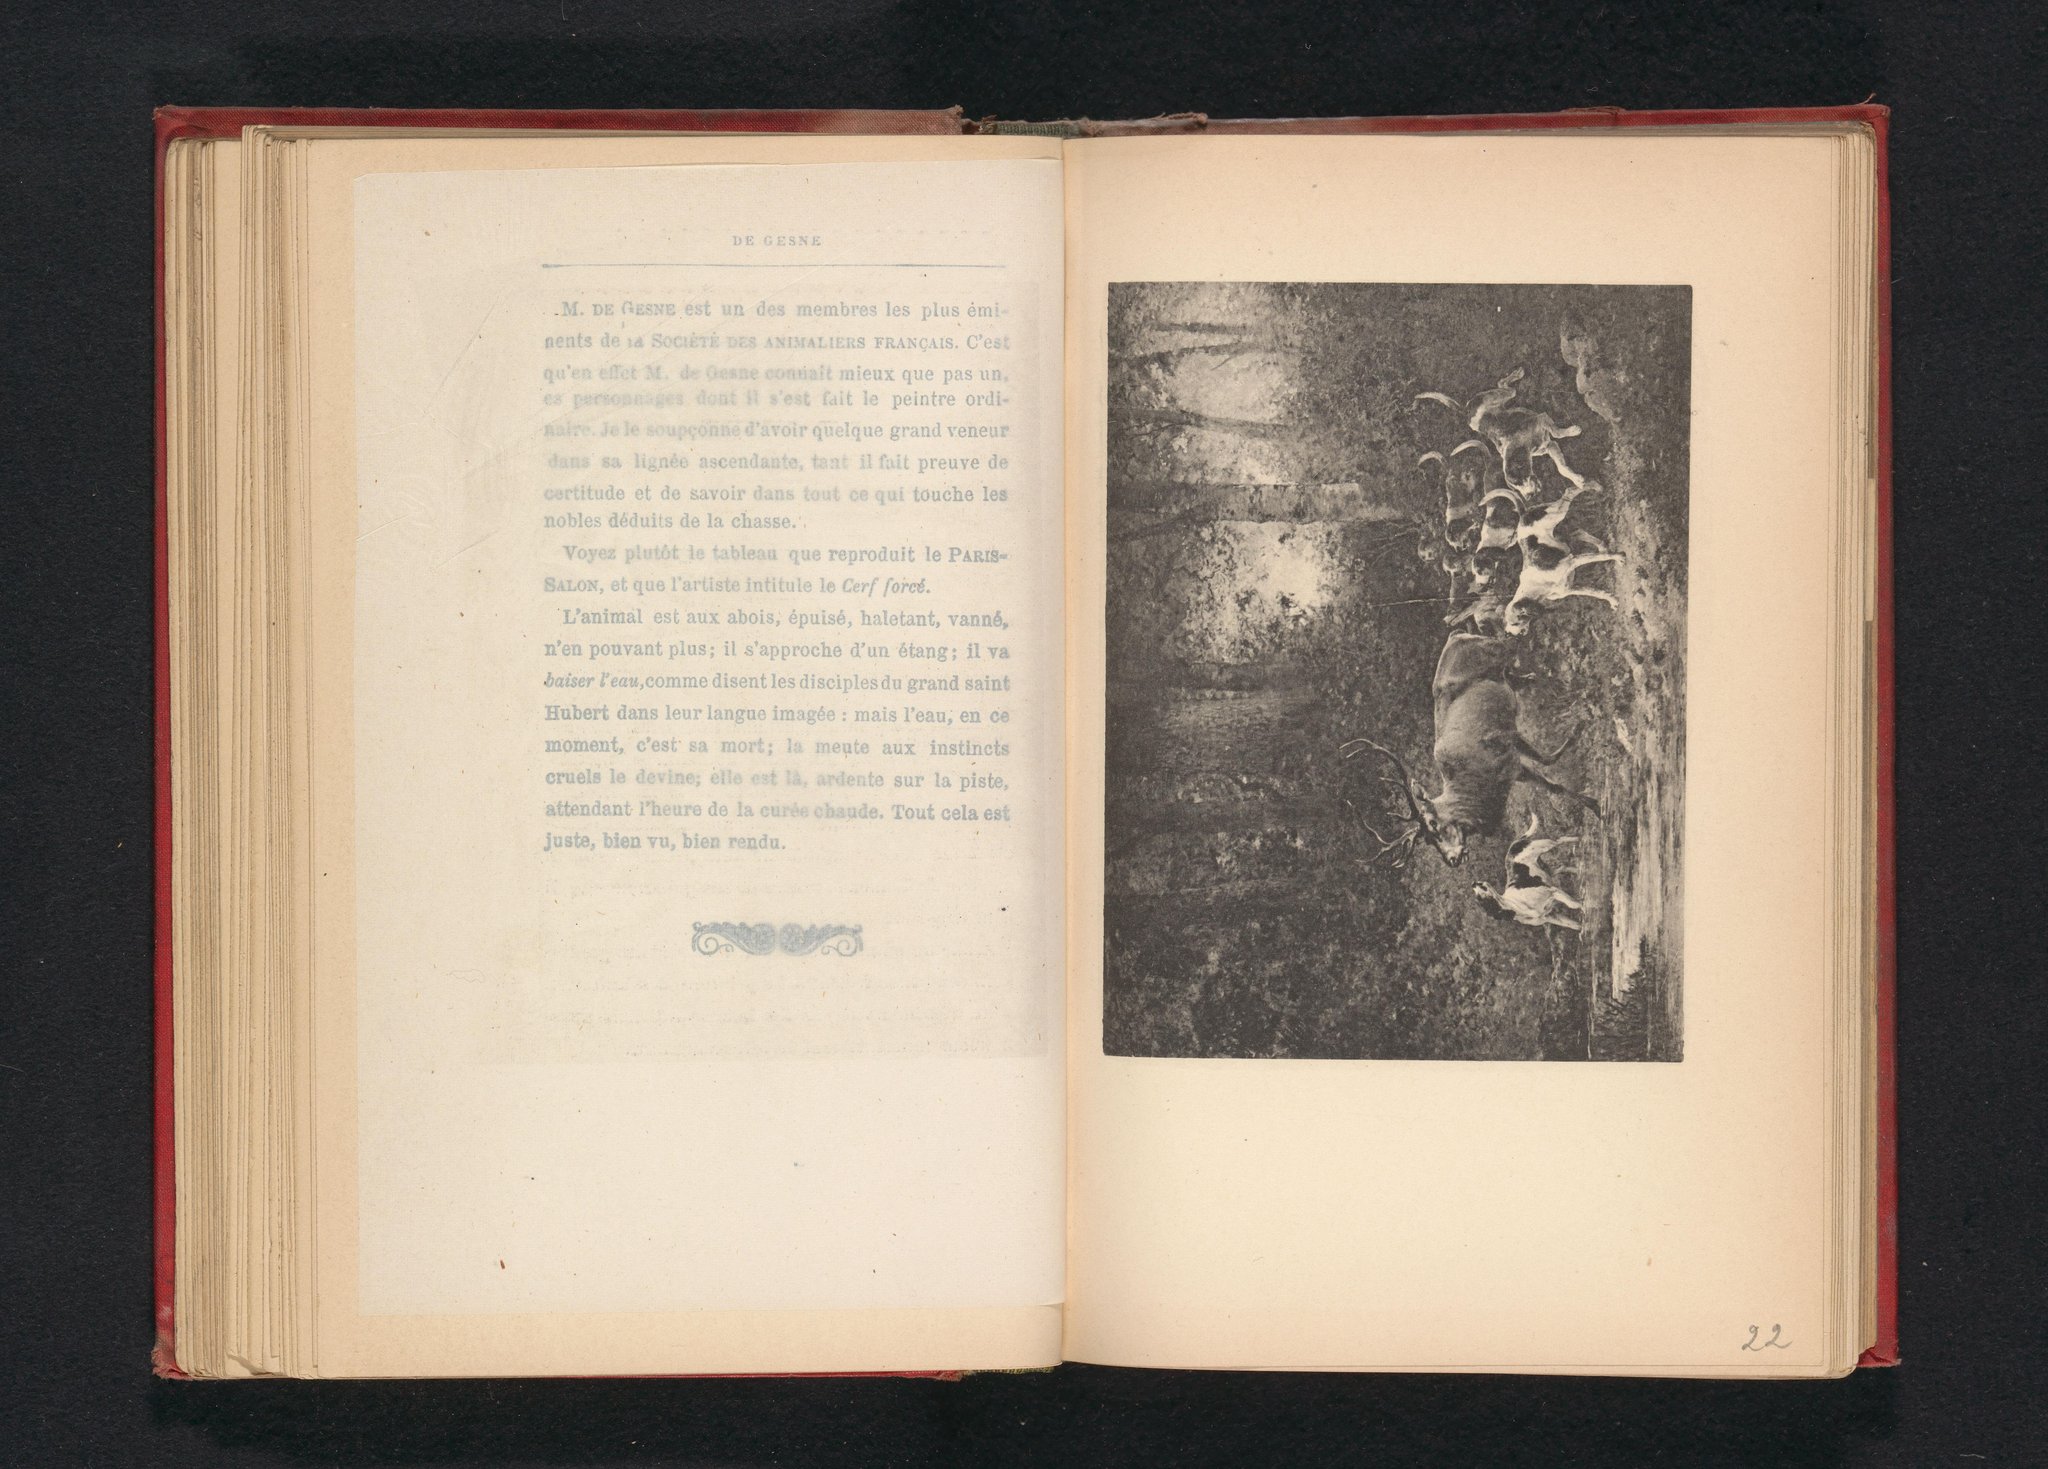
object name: page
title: Fotoreproductie van een schilderij, voorstellende een roedel jachthonden rond een hert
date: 1872-1882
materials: paper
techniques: photograph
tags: hoofed animals: deer, hunting dogs